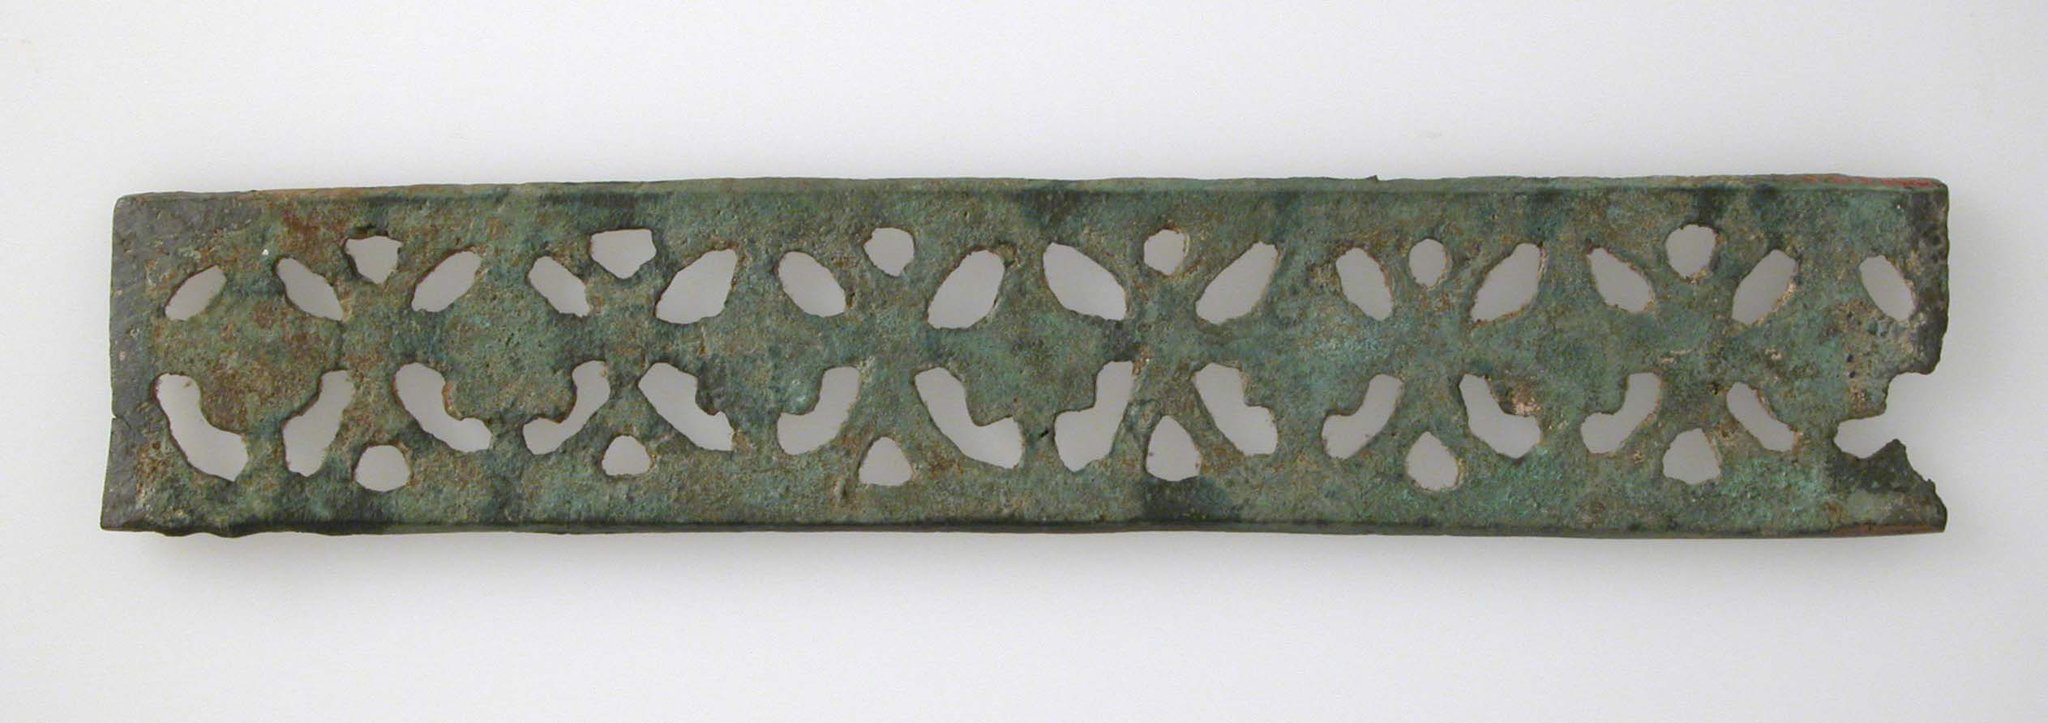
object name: panel from a choros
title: Panel from a Choros (lighting frame)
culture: byzantine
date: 1101-1400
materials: copper alloy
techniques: casting